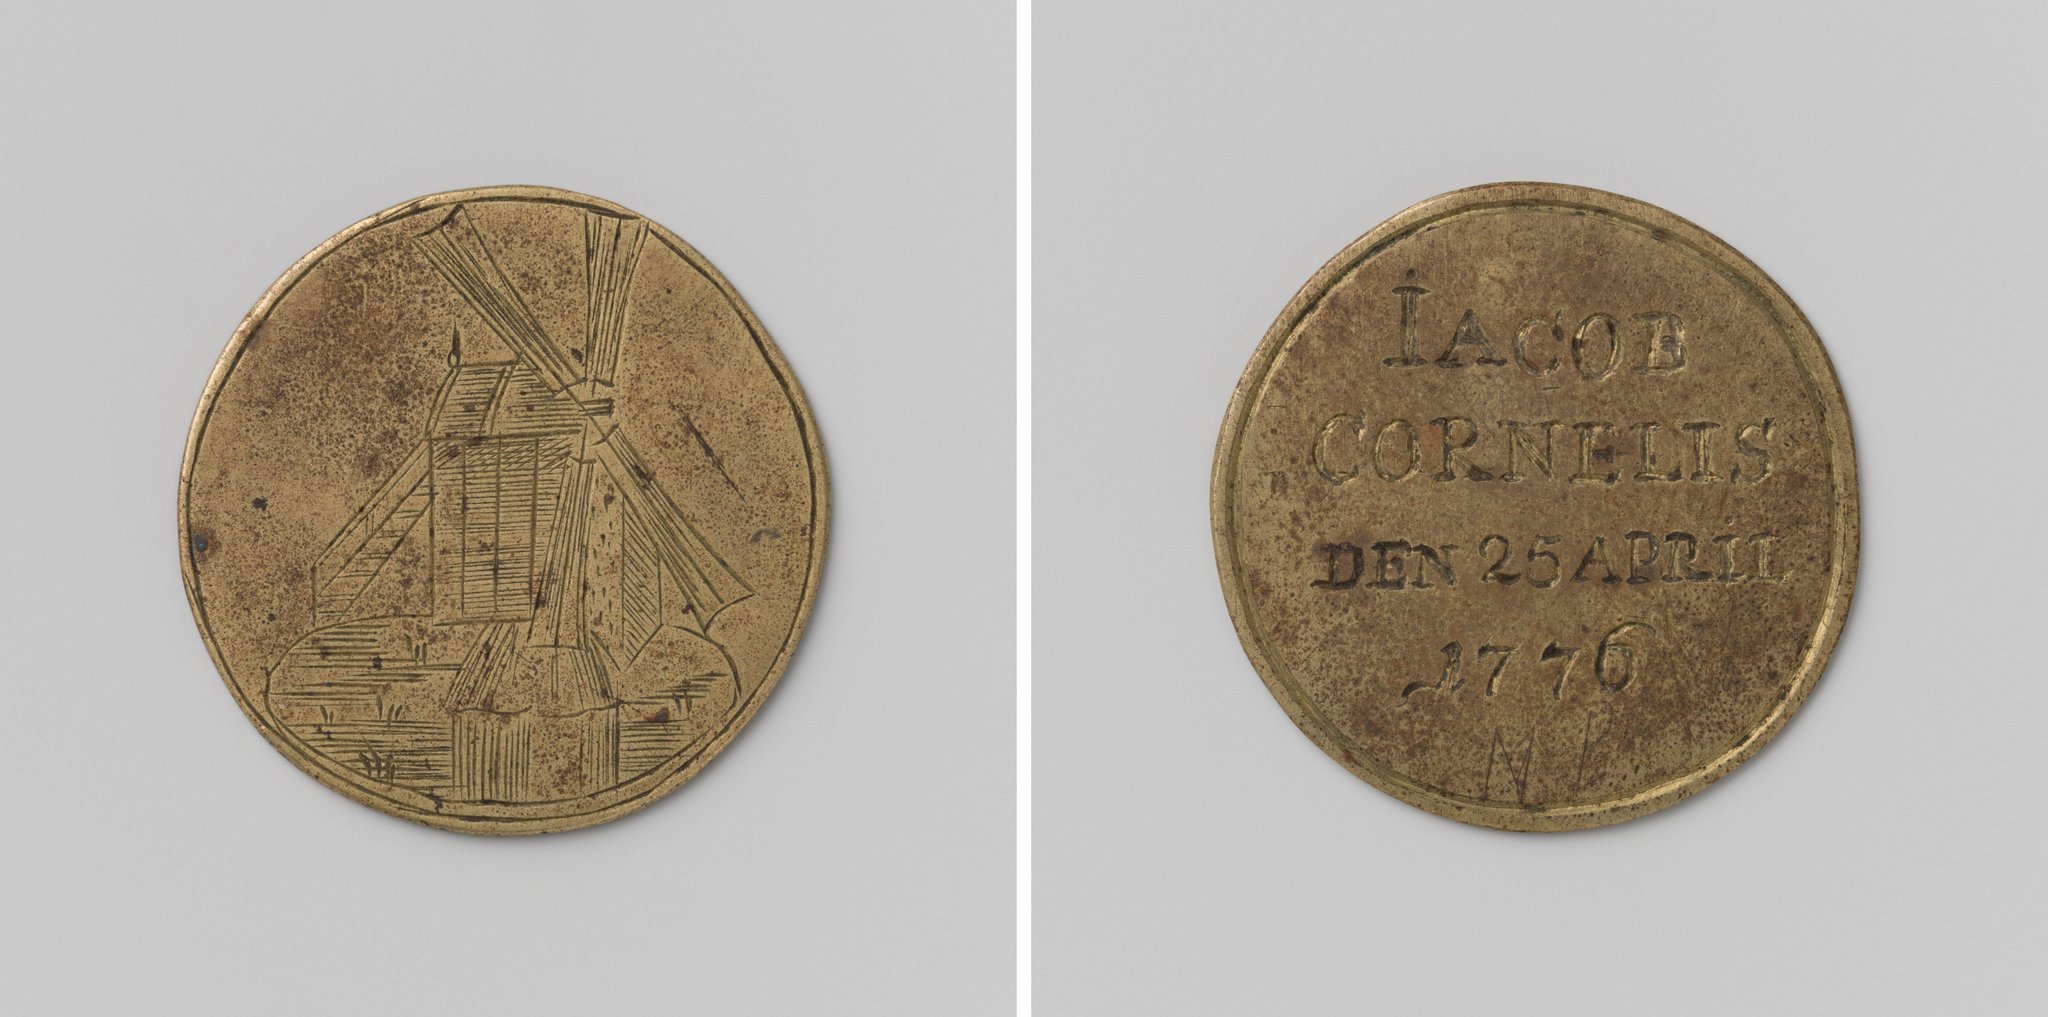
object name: medal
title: Korenmolenaarsgilde van Amsterdam, gildepenning van Jacob Cornelis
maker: Anonymous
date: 1776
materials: brass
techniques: engraving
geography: amsterdam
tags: jacob cornelis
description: Messing penning. Voorzijde: korenmolen. Keerzijde: opschrift